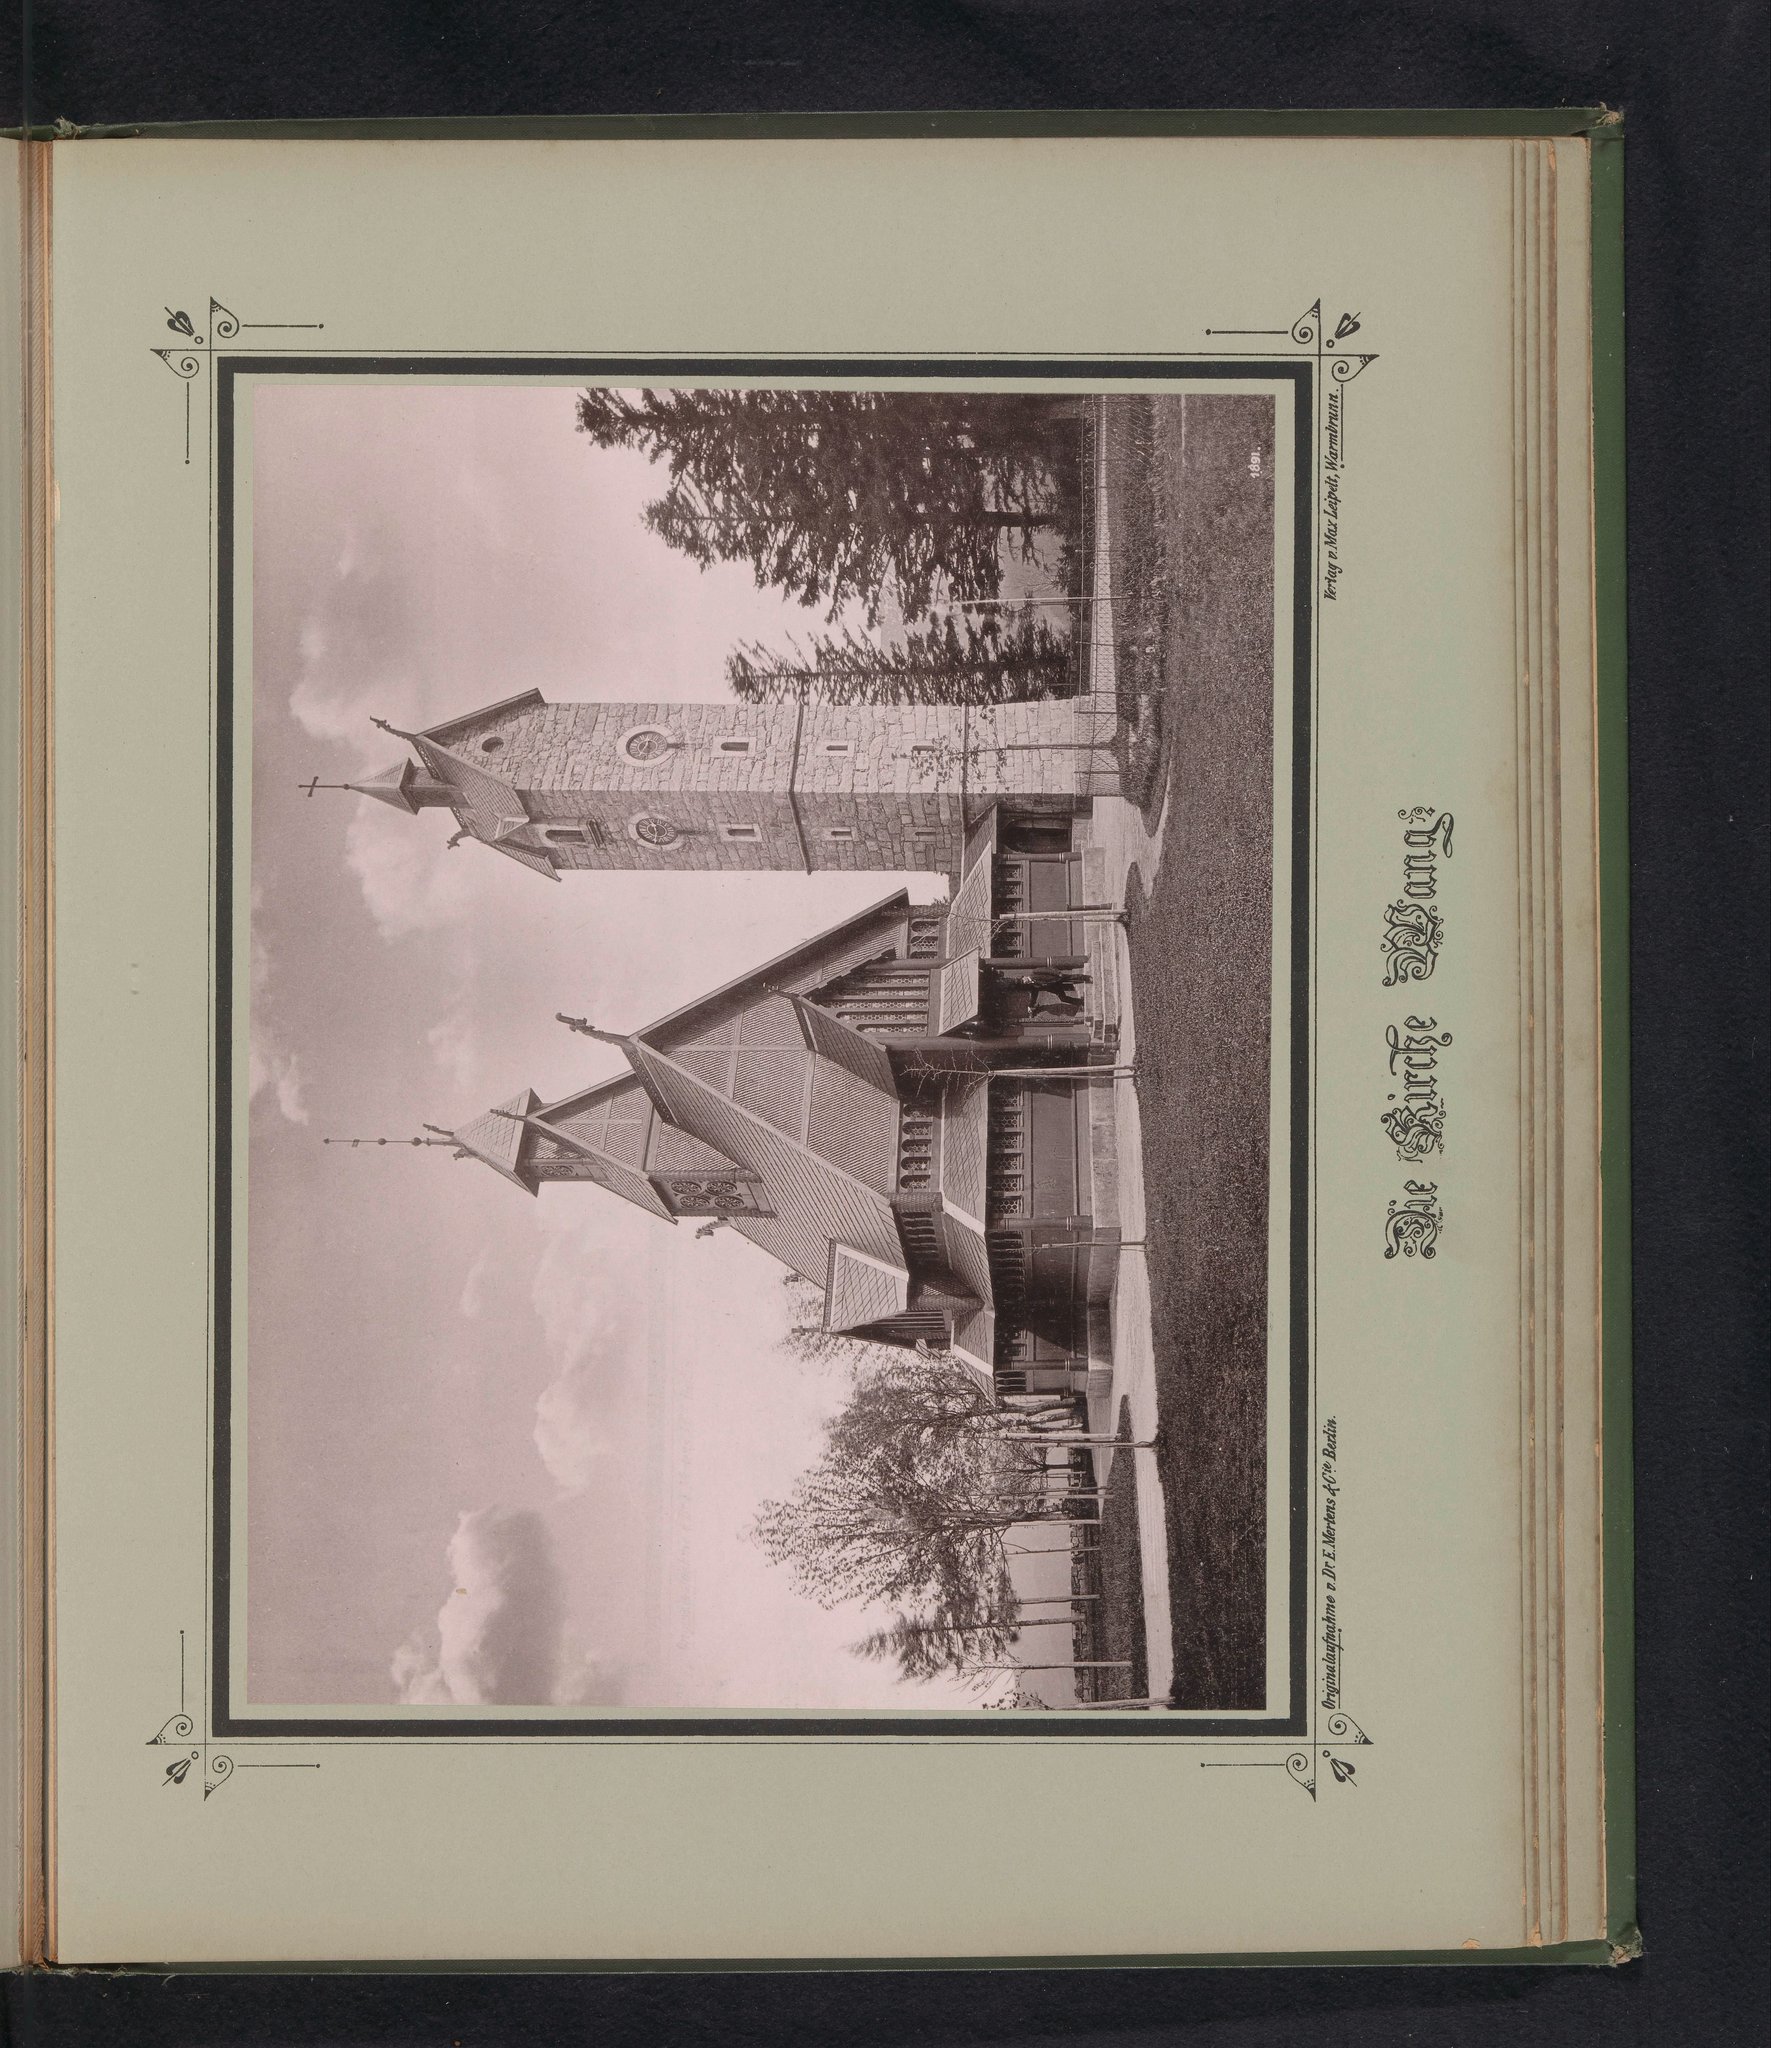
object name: page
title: Die Kirche Wang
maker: max leipelt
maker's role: publisher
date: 1891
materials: paper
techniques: photograph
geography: warmbrunn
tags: church (exterior)